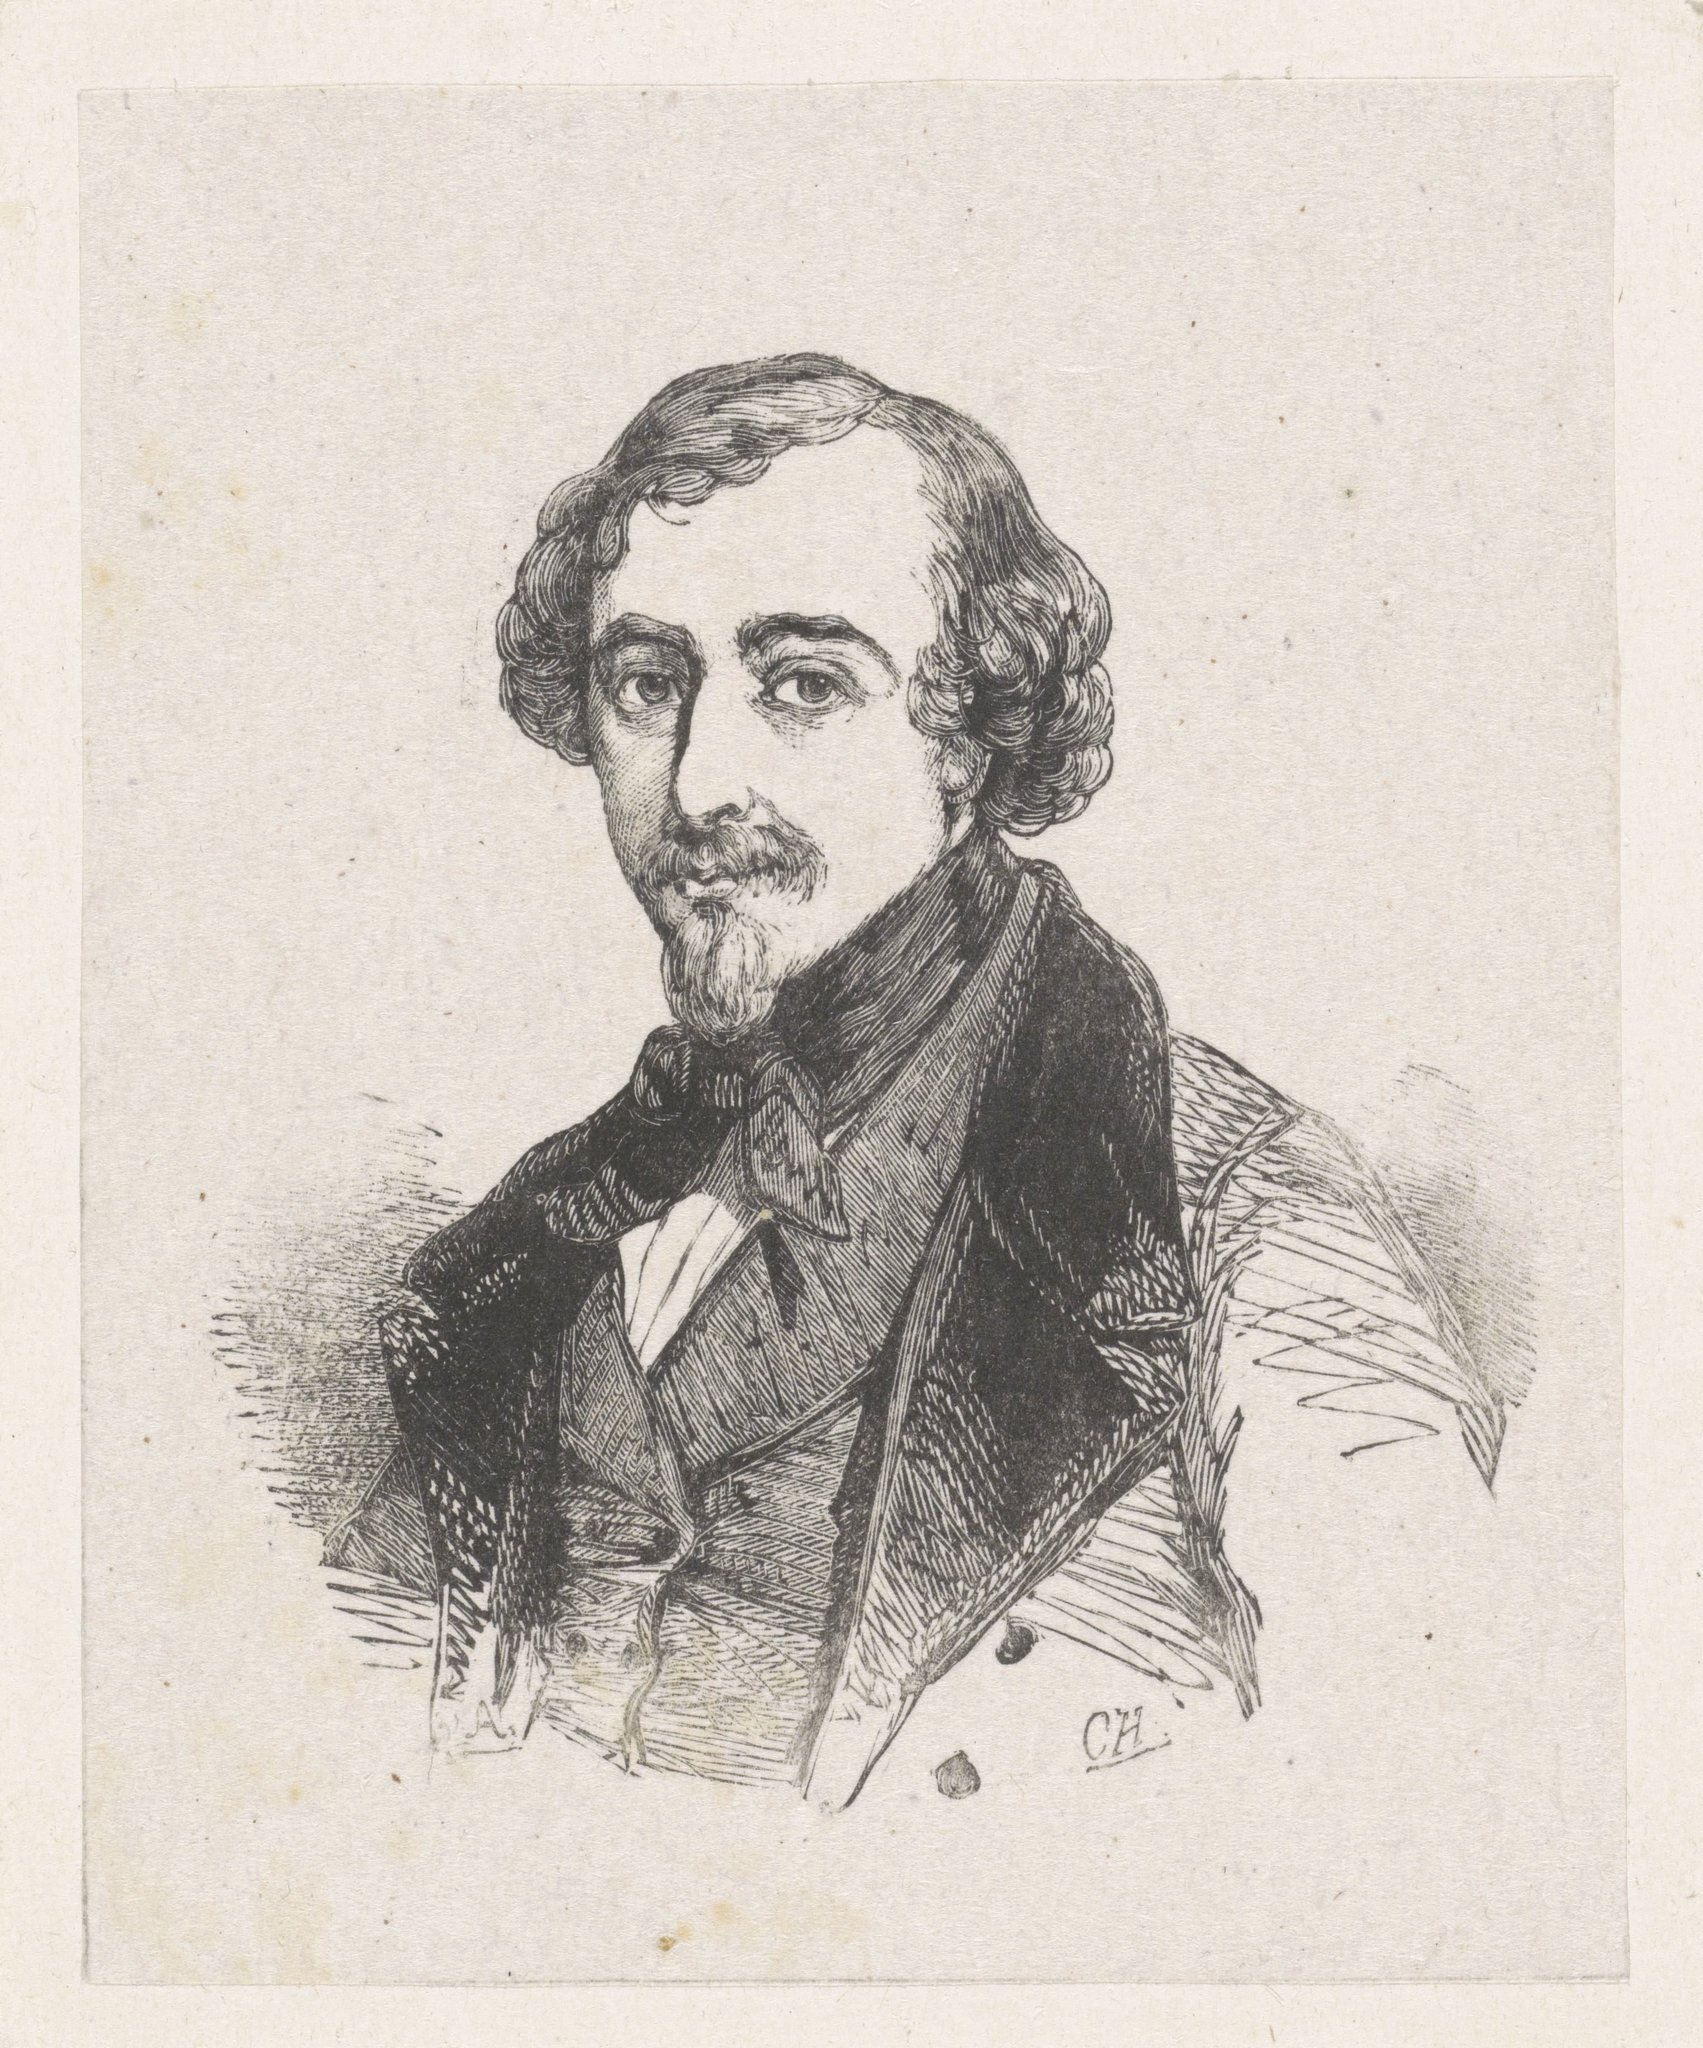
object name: print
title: Portret van Christiaan Immerzeel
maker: coenraad hamburger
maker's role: draughtsman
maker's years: 1809-1891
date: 1841-1842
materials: paper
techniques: engraving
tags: the hague, print maker, christiaan immerzeel, historical persons, portrait, self-portrait of painter, portrait, self-portrait of artist, portrait, self-portrait of draughtsman